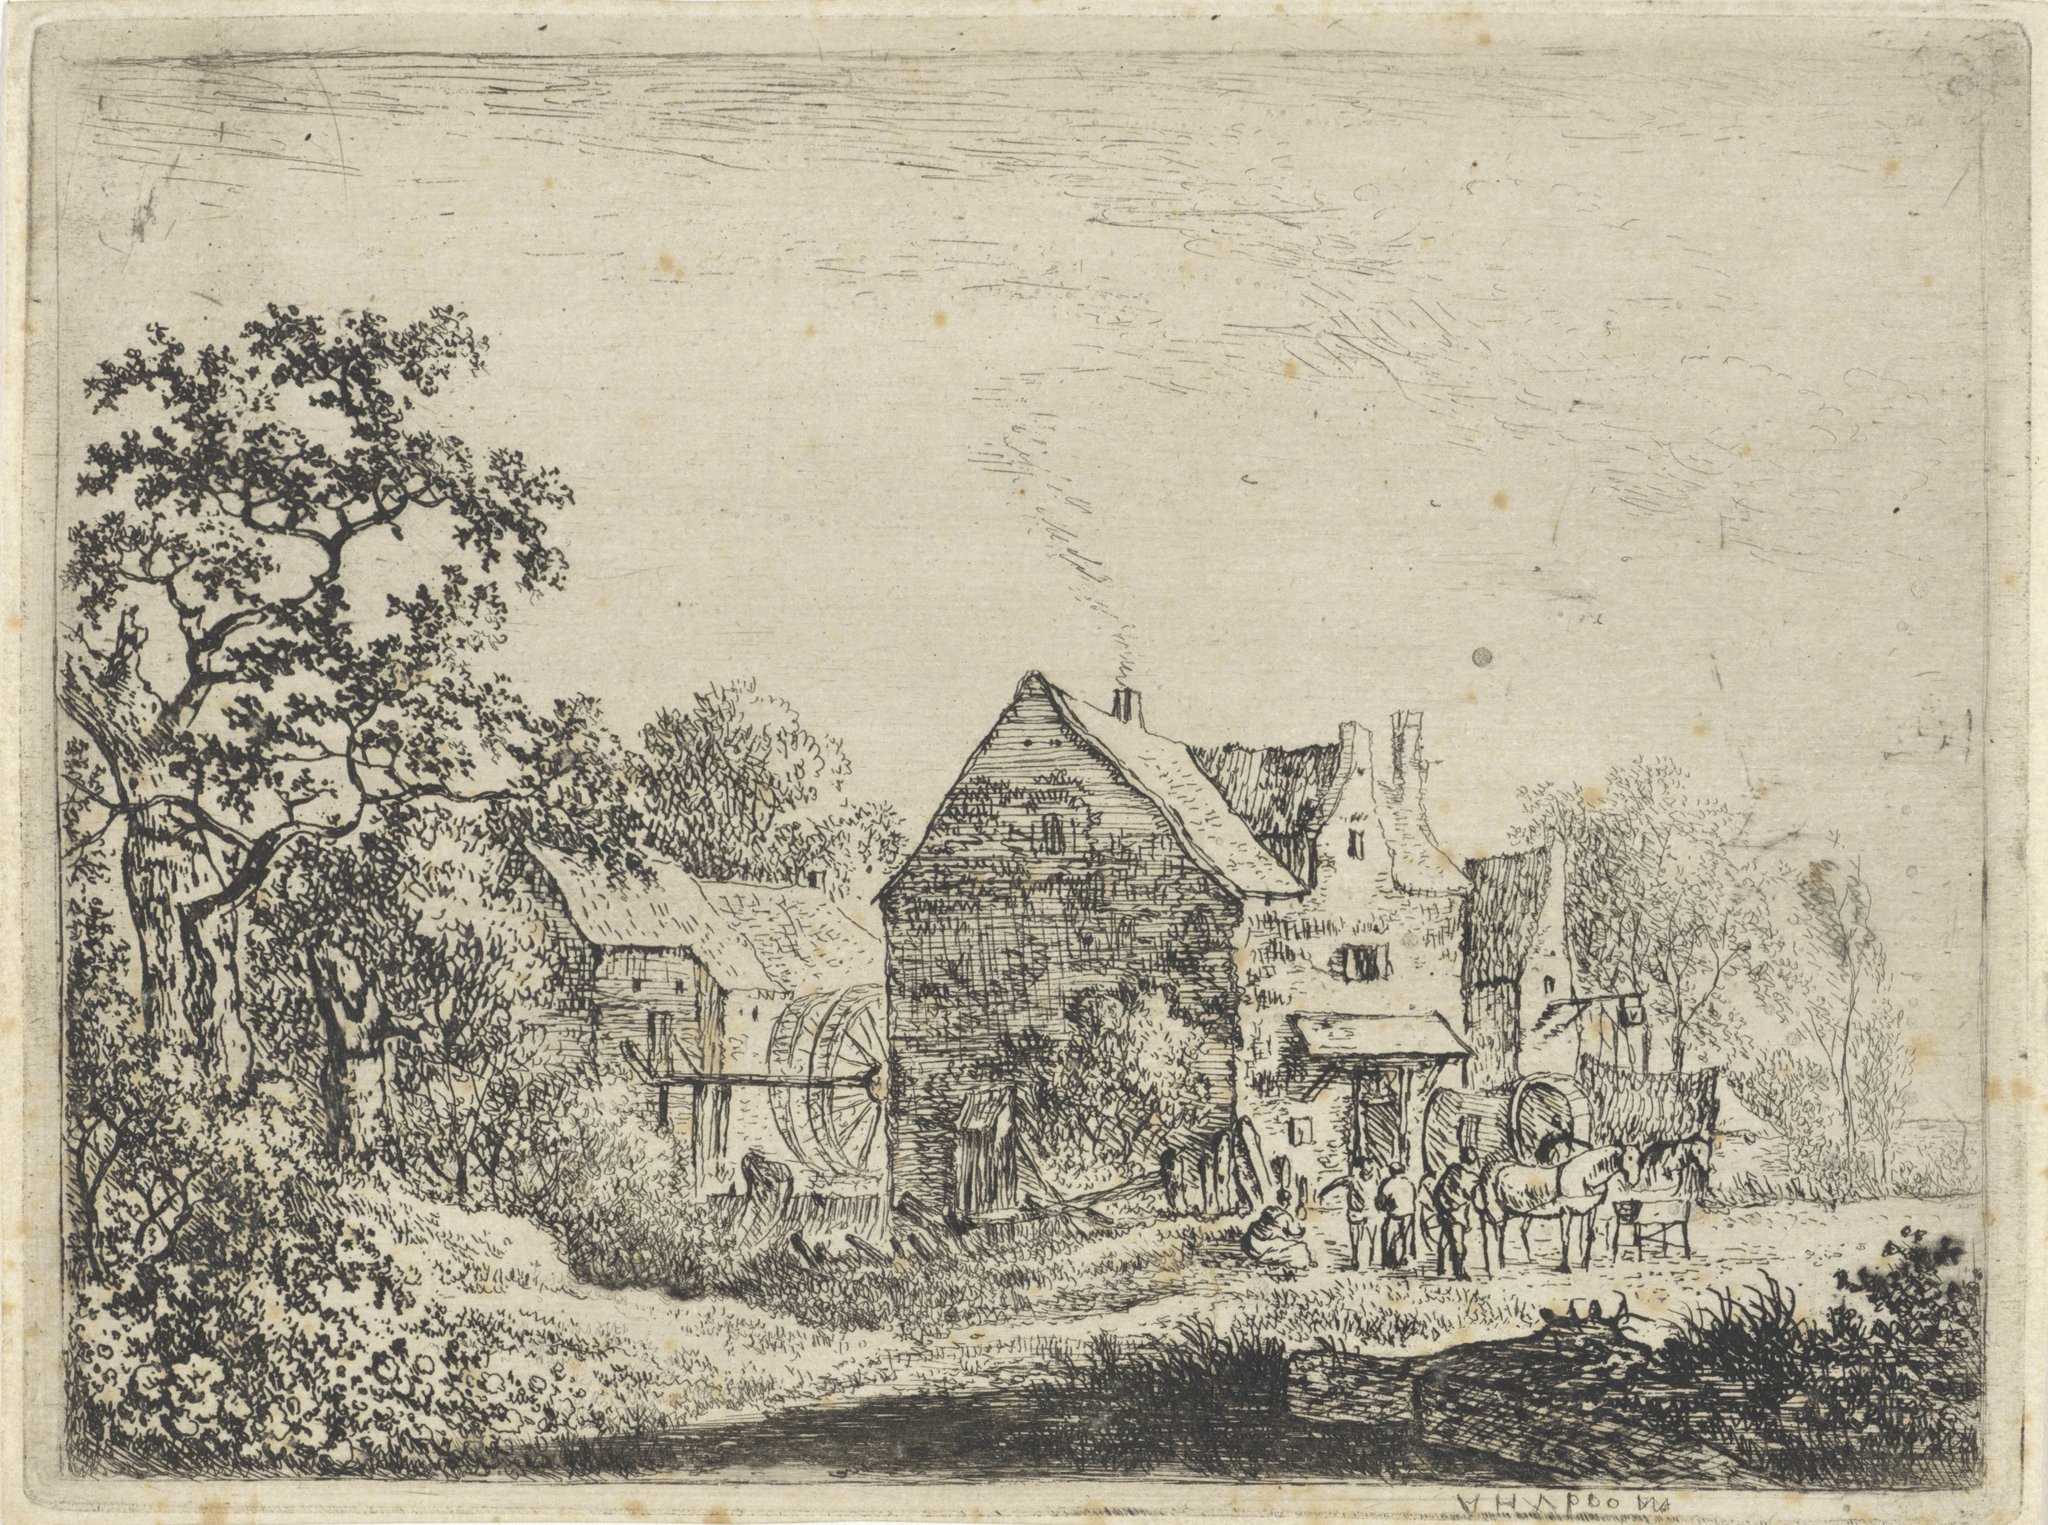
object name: print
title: Landschappen (kopieën)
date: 1615-1652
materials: paper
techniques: engraving, etching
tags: farm or solitary house in landscape, haarlem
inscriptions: collector's mark: Lugt 240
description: Kopie in spiegelbeeld naar een prent van Esaias van de Velde